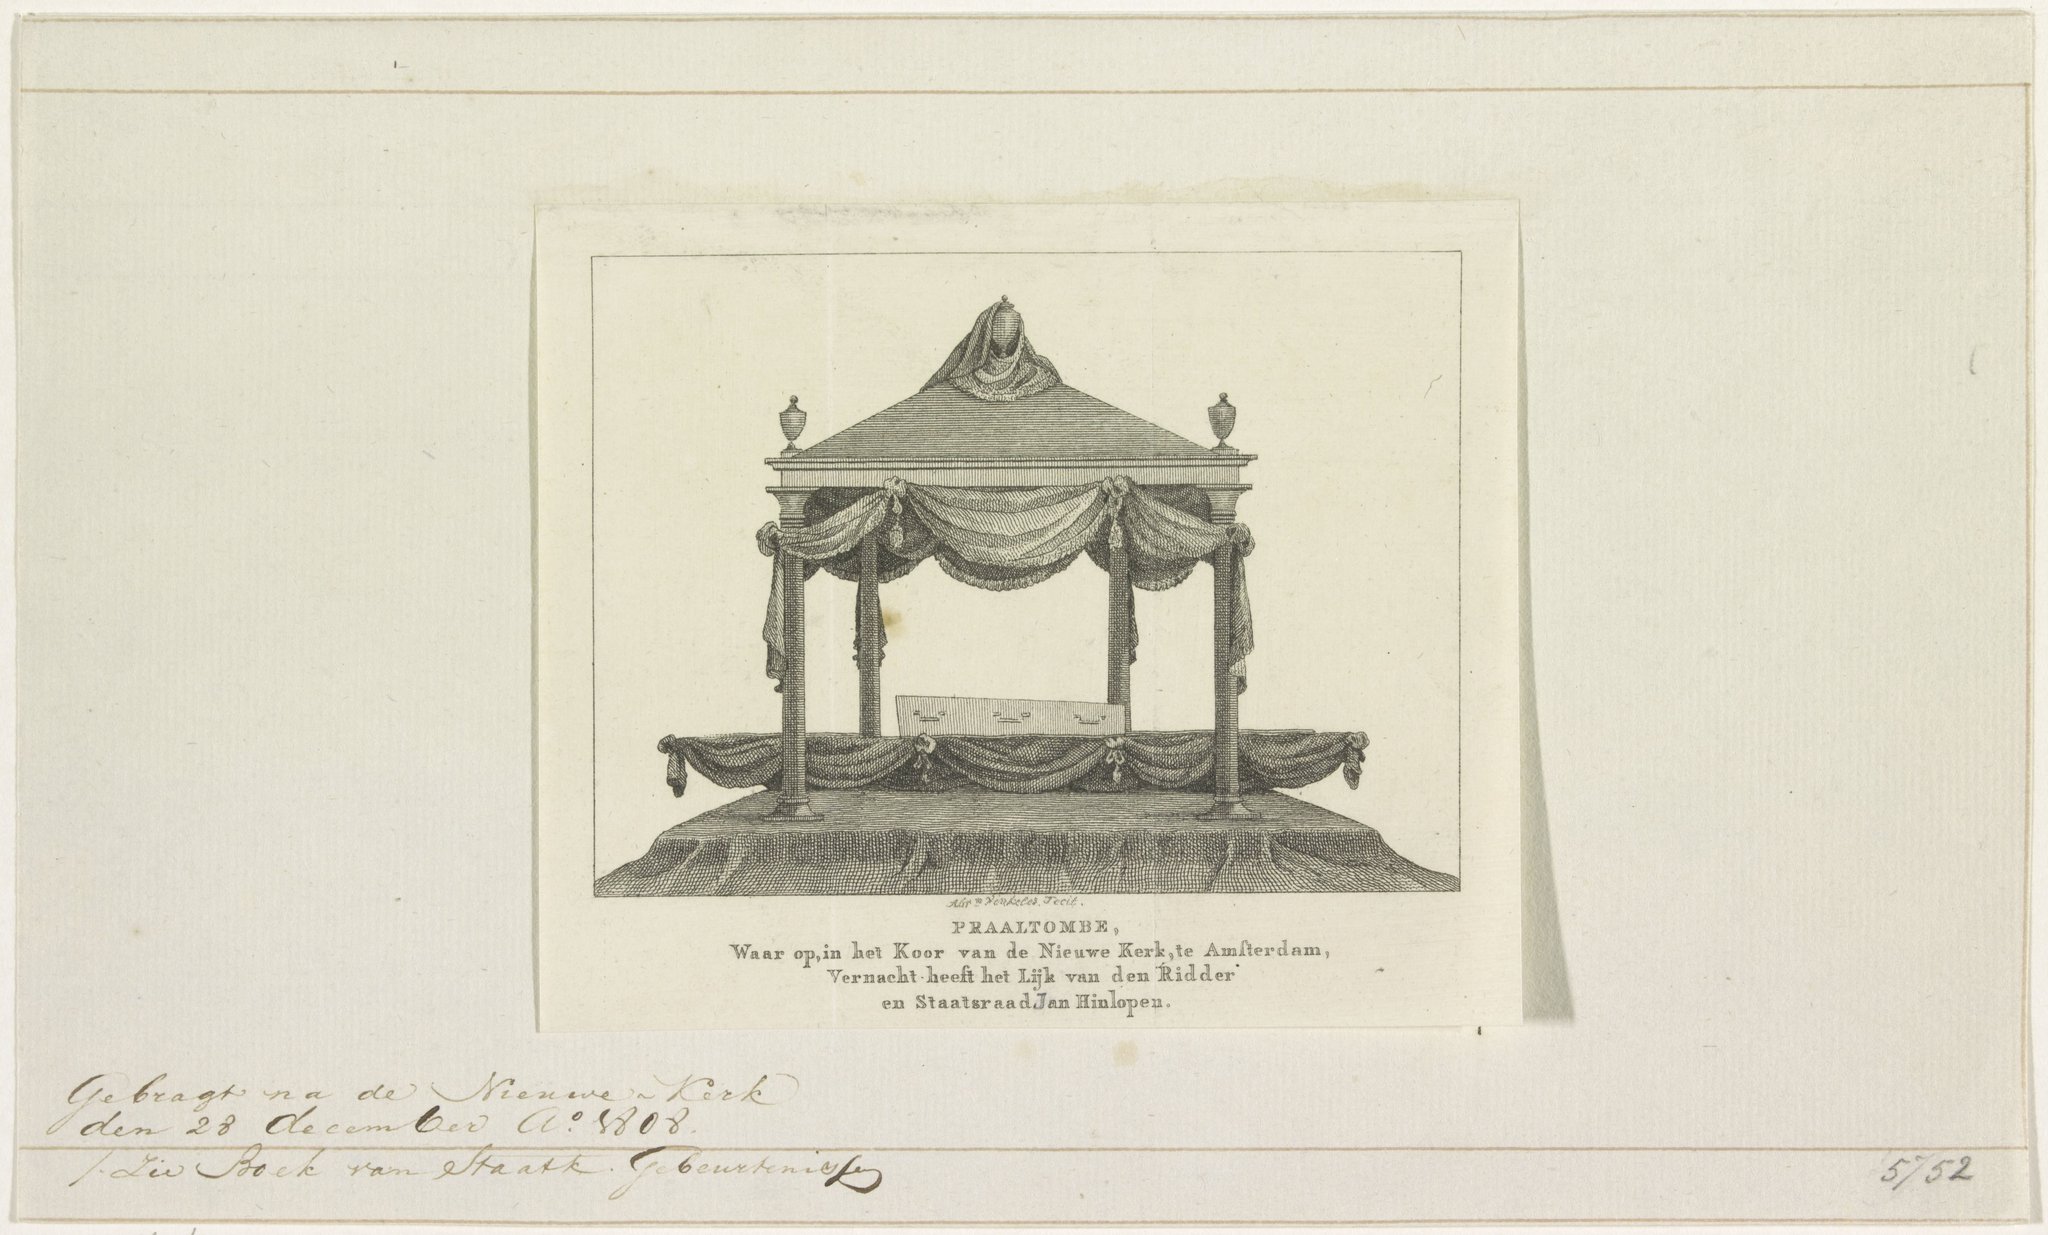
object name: print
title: Praaltombe, Waar op, in het Koor van de Nieuwe Kerk, te Amsterdam, Vernacht heeft het Lijk van den Ridder en Staatsraad Jan Hinlopen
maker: abraham vinkeles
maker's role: draughtsman, print maker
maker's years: 1790-1864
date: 1808-1809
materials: paper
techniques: etching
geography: netherlands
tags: utrecht, amsterdam, grave-building, monumental tomb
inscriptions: inscription: ‘Gebragt na de Nieuwe Kerk den 28 december Ao. 1808 / Zie Boek van Staatk. Gebeurtenissen.’, collector's mark: Lugt 2228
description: Praalgraf voor Jan Hinlopen, overleden op 21 december 1808, in de Nieuwe Kerk te Amsterdam. Volgend een opschrift op de oude monture werd het lichaam op 28 december overgebracht naar de kerk.